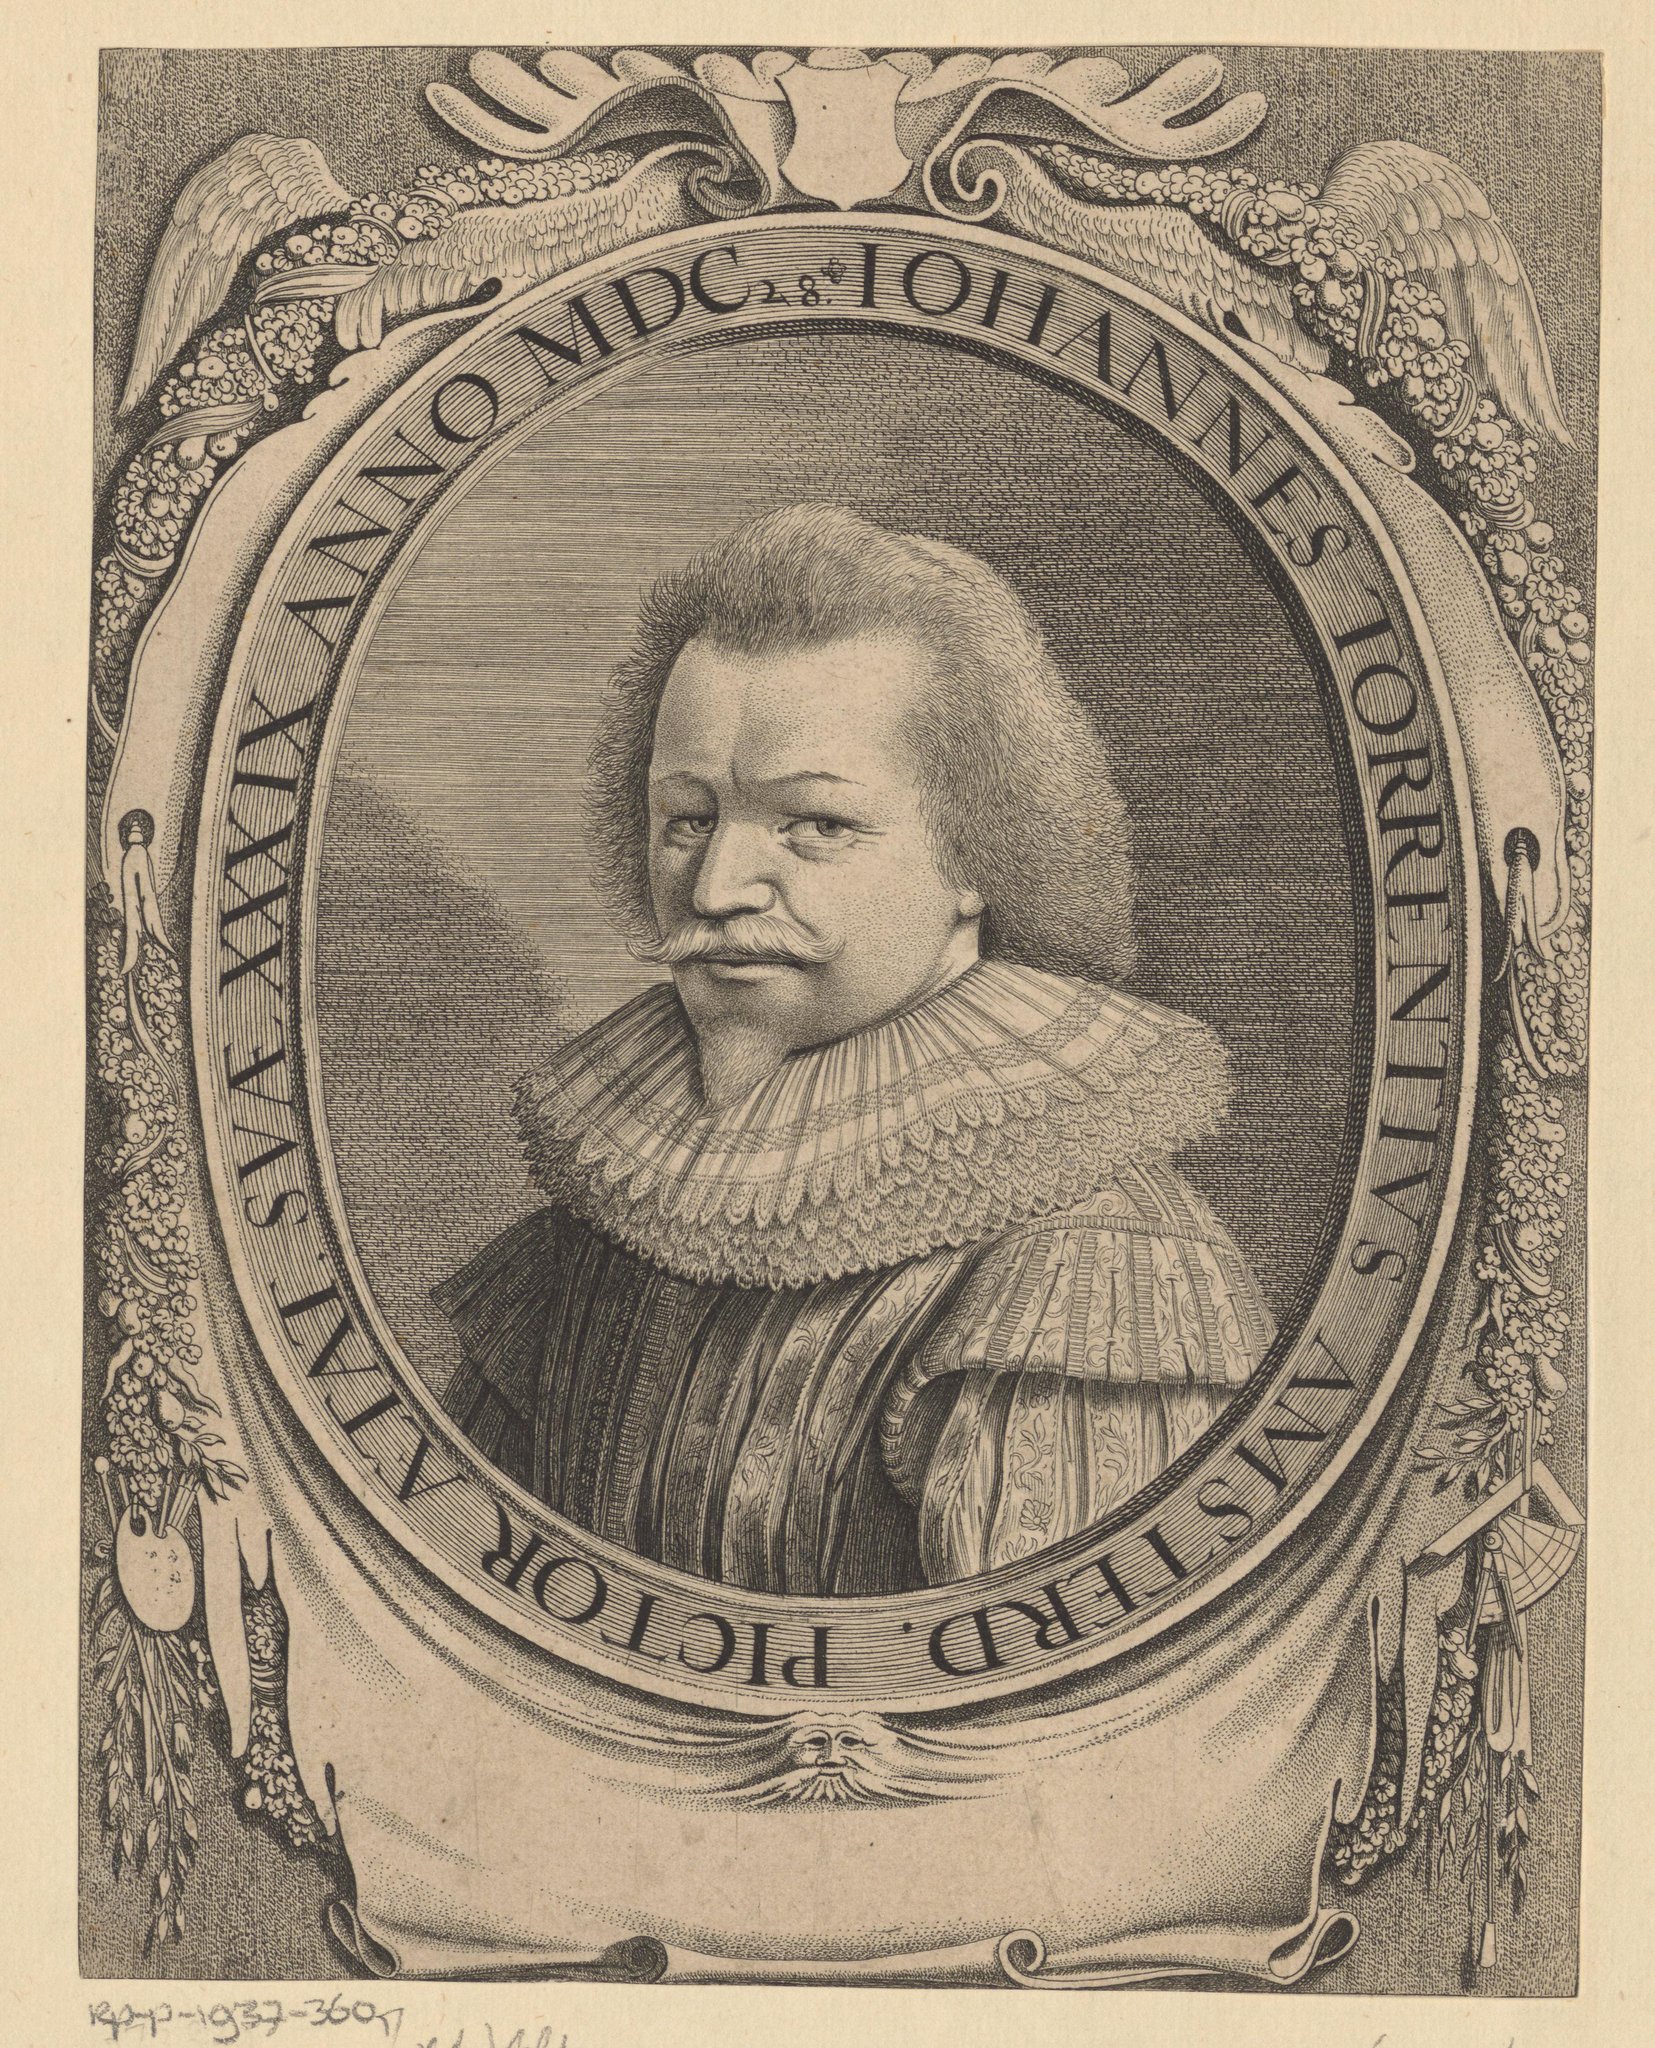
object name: print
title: Portret van Johannes Torrentius op 39-jarige leeftijd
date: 1628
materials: paper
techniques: engraving, etching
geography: netherlands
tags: johannes torrentius, historical persons, portrait, self-portrait of artist, portrait, self-portrait of graphic artist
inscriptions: collector's mark: Lugt 2228, collector's mark: Lugt 2760